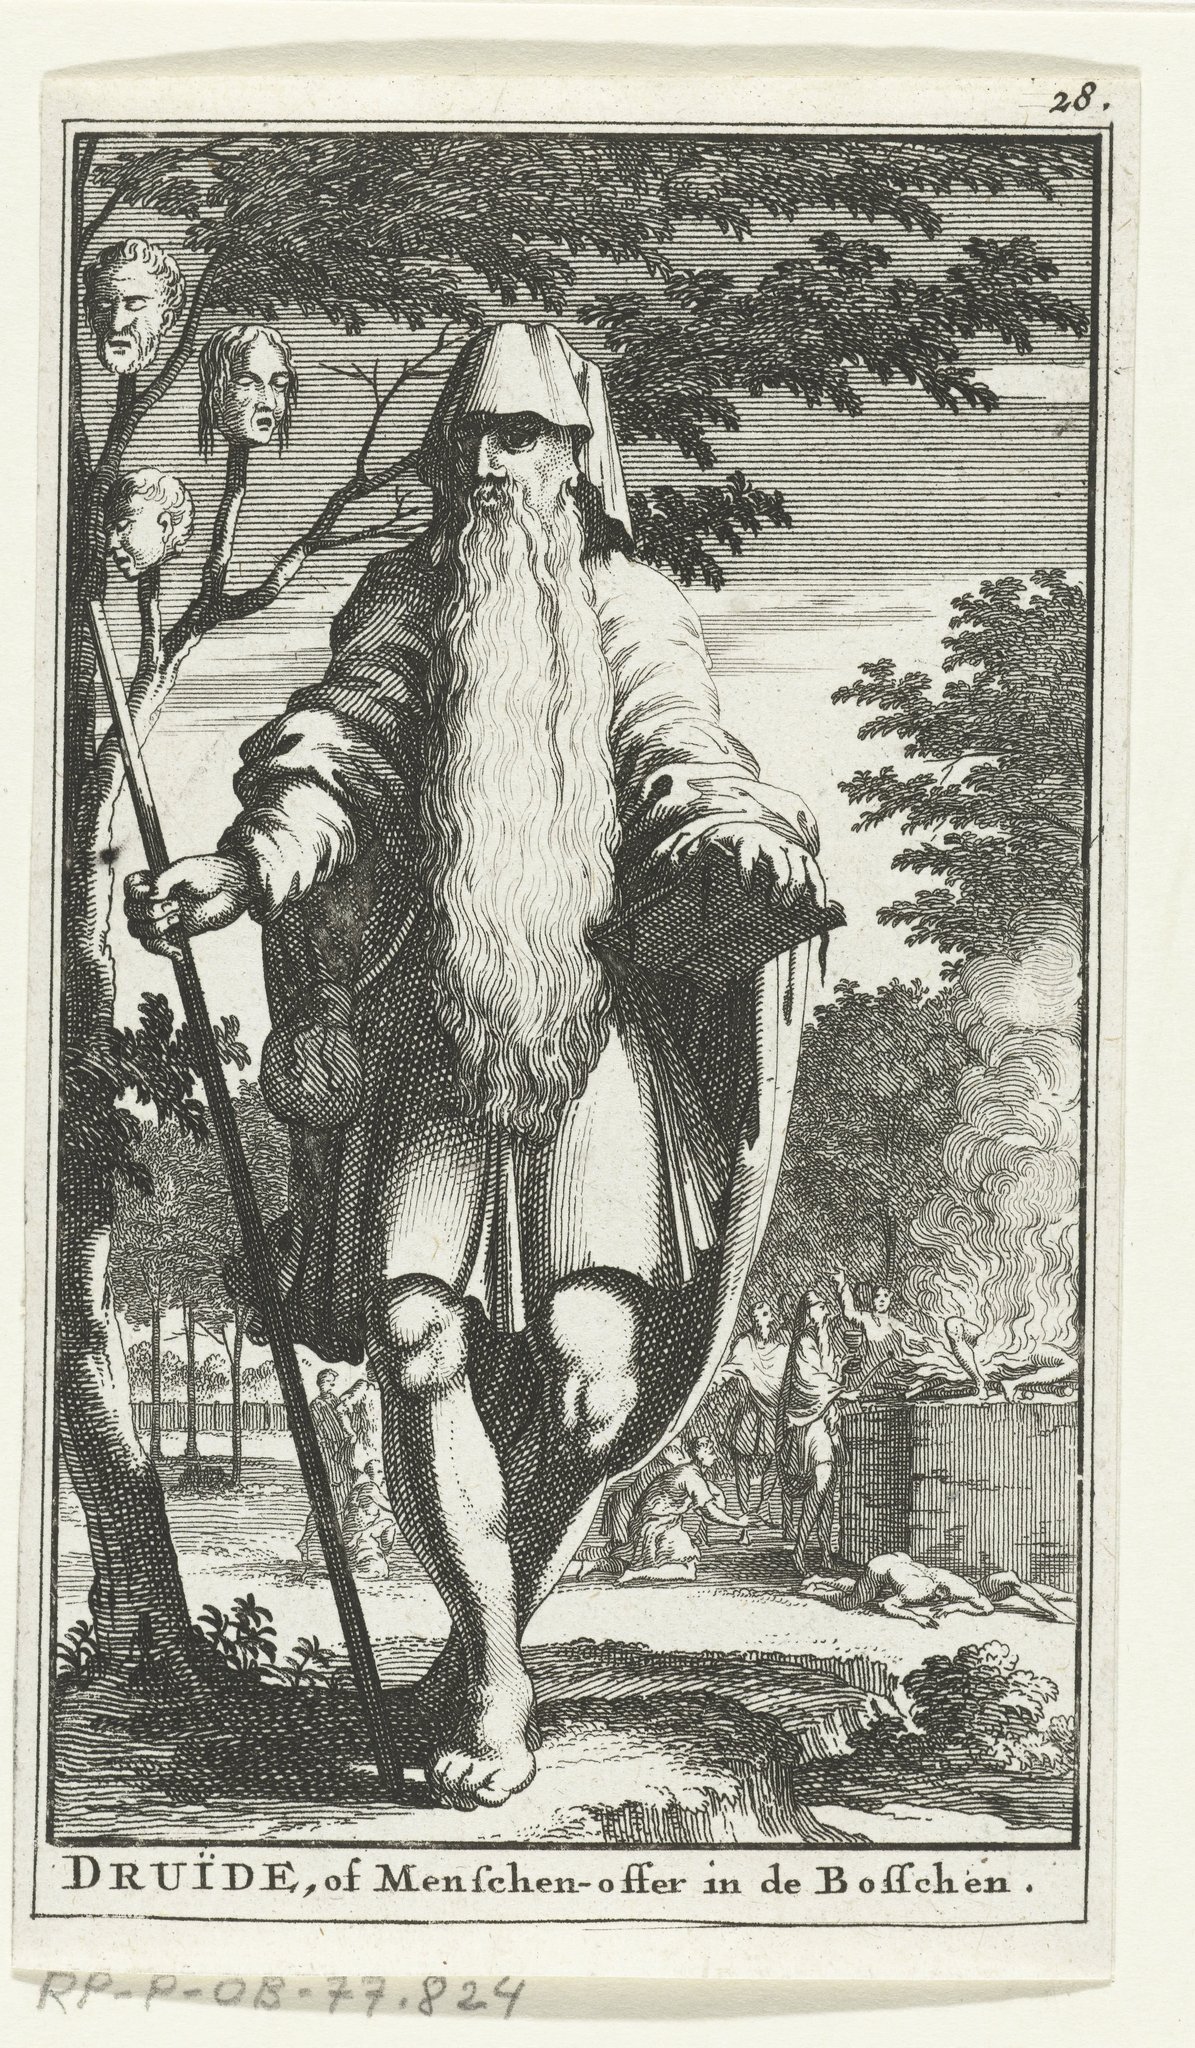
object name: history print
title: Druïde, of Menschen-offer in de Bosschen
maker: Anonymous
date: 1712-1714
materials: paper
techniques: etching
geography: netherlands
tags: extinct, 'historical' peoples (with name)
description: Gebruikt als illustratie in: Hugo de Groots Antiquitates Germanicæ, of Hoogduitsche oudtheden: waar in de gelegentheid en zeeden der Germaanen, beschreeven door Tacitus, naaukeurig verklaart, en met printverbeeldingen opgeheldert worden: benevens H. Grotius verhandeling van de oudtheid der Batavische republyk. Amsterdam: Jacob van Royen, 1714.